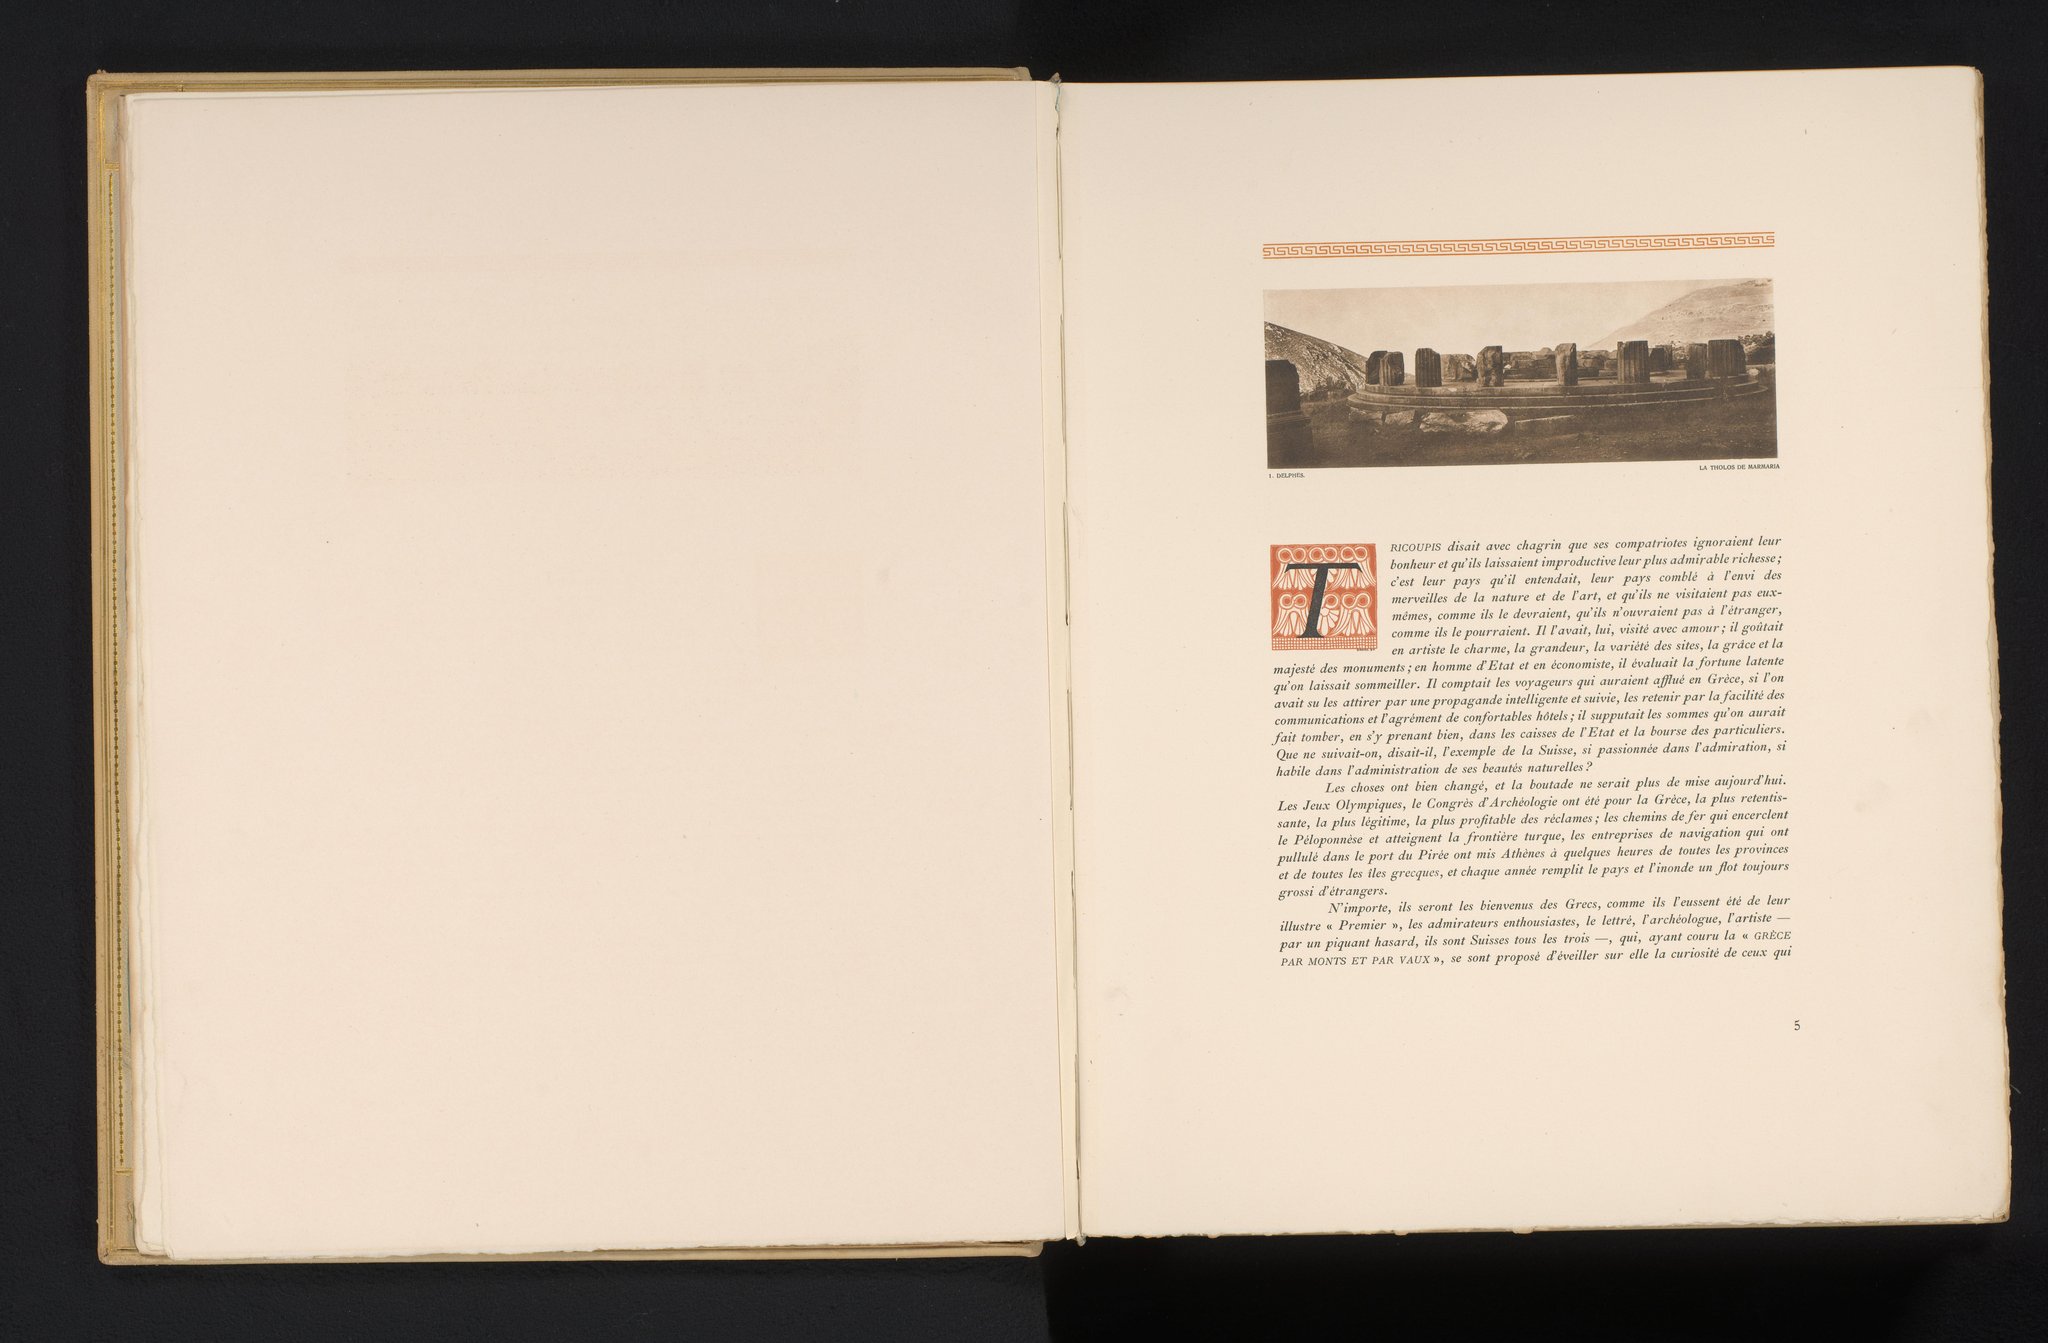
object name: page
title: Delphes, la Tholos de Marmaria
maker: frédéric boissonnas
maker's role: fotograaf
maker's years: 1858-1946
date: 1905-1910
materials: paper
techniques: photograph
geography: berlin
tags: landscape with ruins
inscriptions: number: ‘1.’